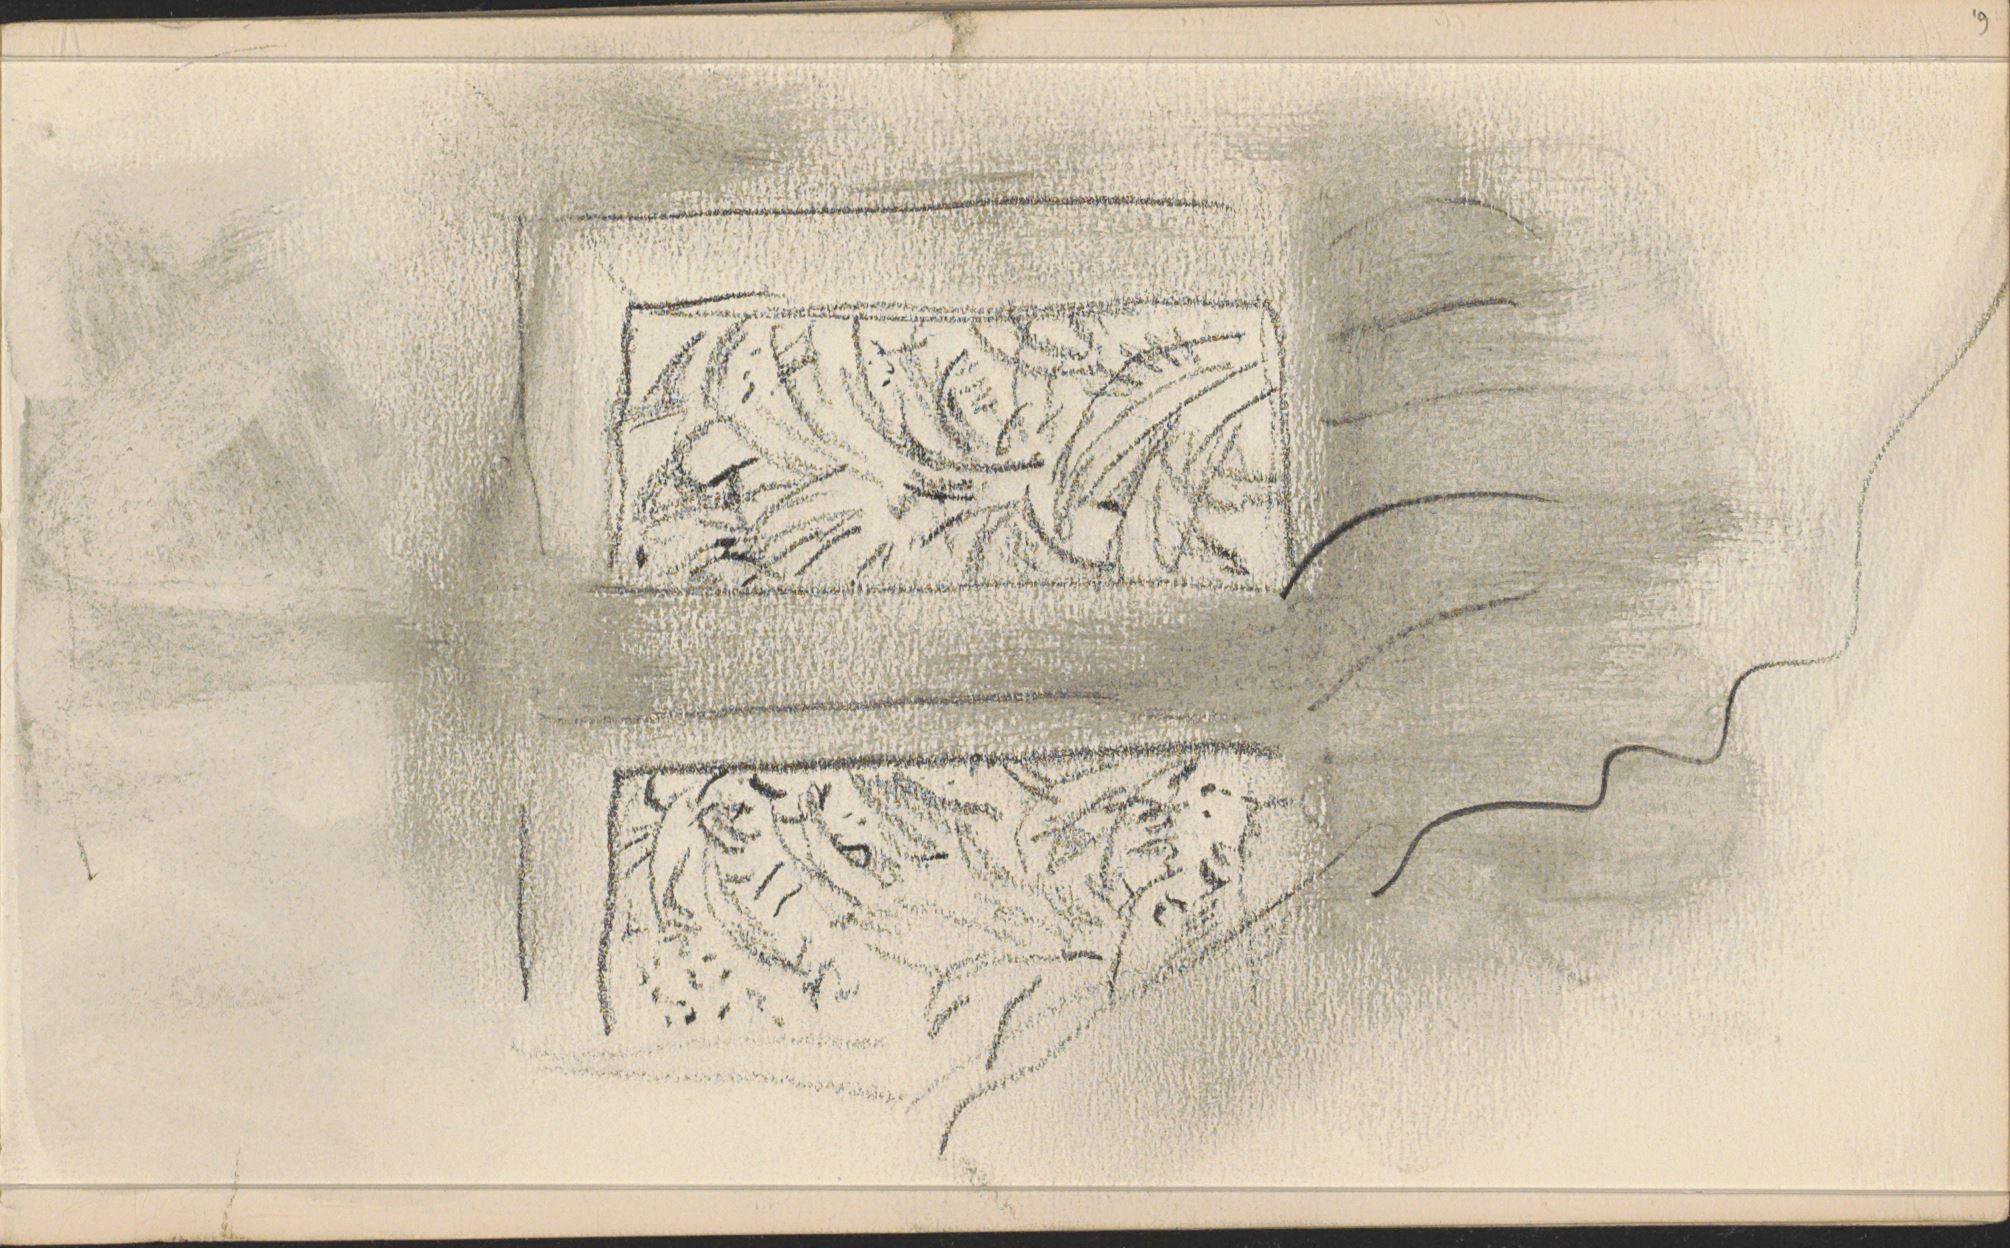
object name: sketchbook leaf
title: Vensters met uitzicht op palmbomen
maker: marius bauer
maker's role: draughtsman, print maker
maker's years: 1867-1932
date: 1922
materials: paper, pencil, watercolor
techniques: brush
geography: algeria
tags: window, trees: palm-tree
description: Pagina 19 uit een schetsboek met 31 bladen.